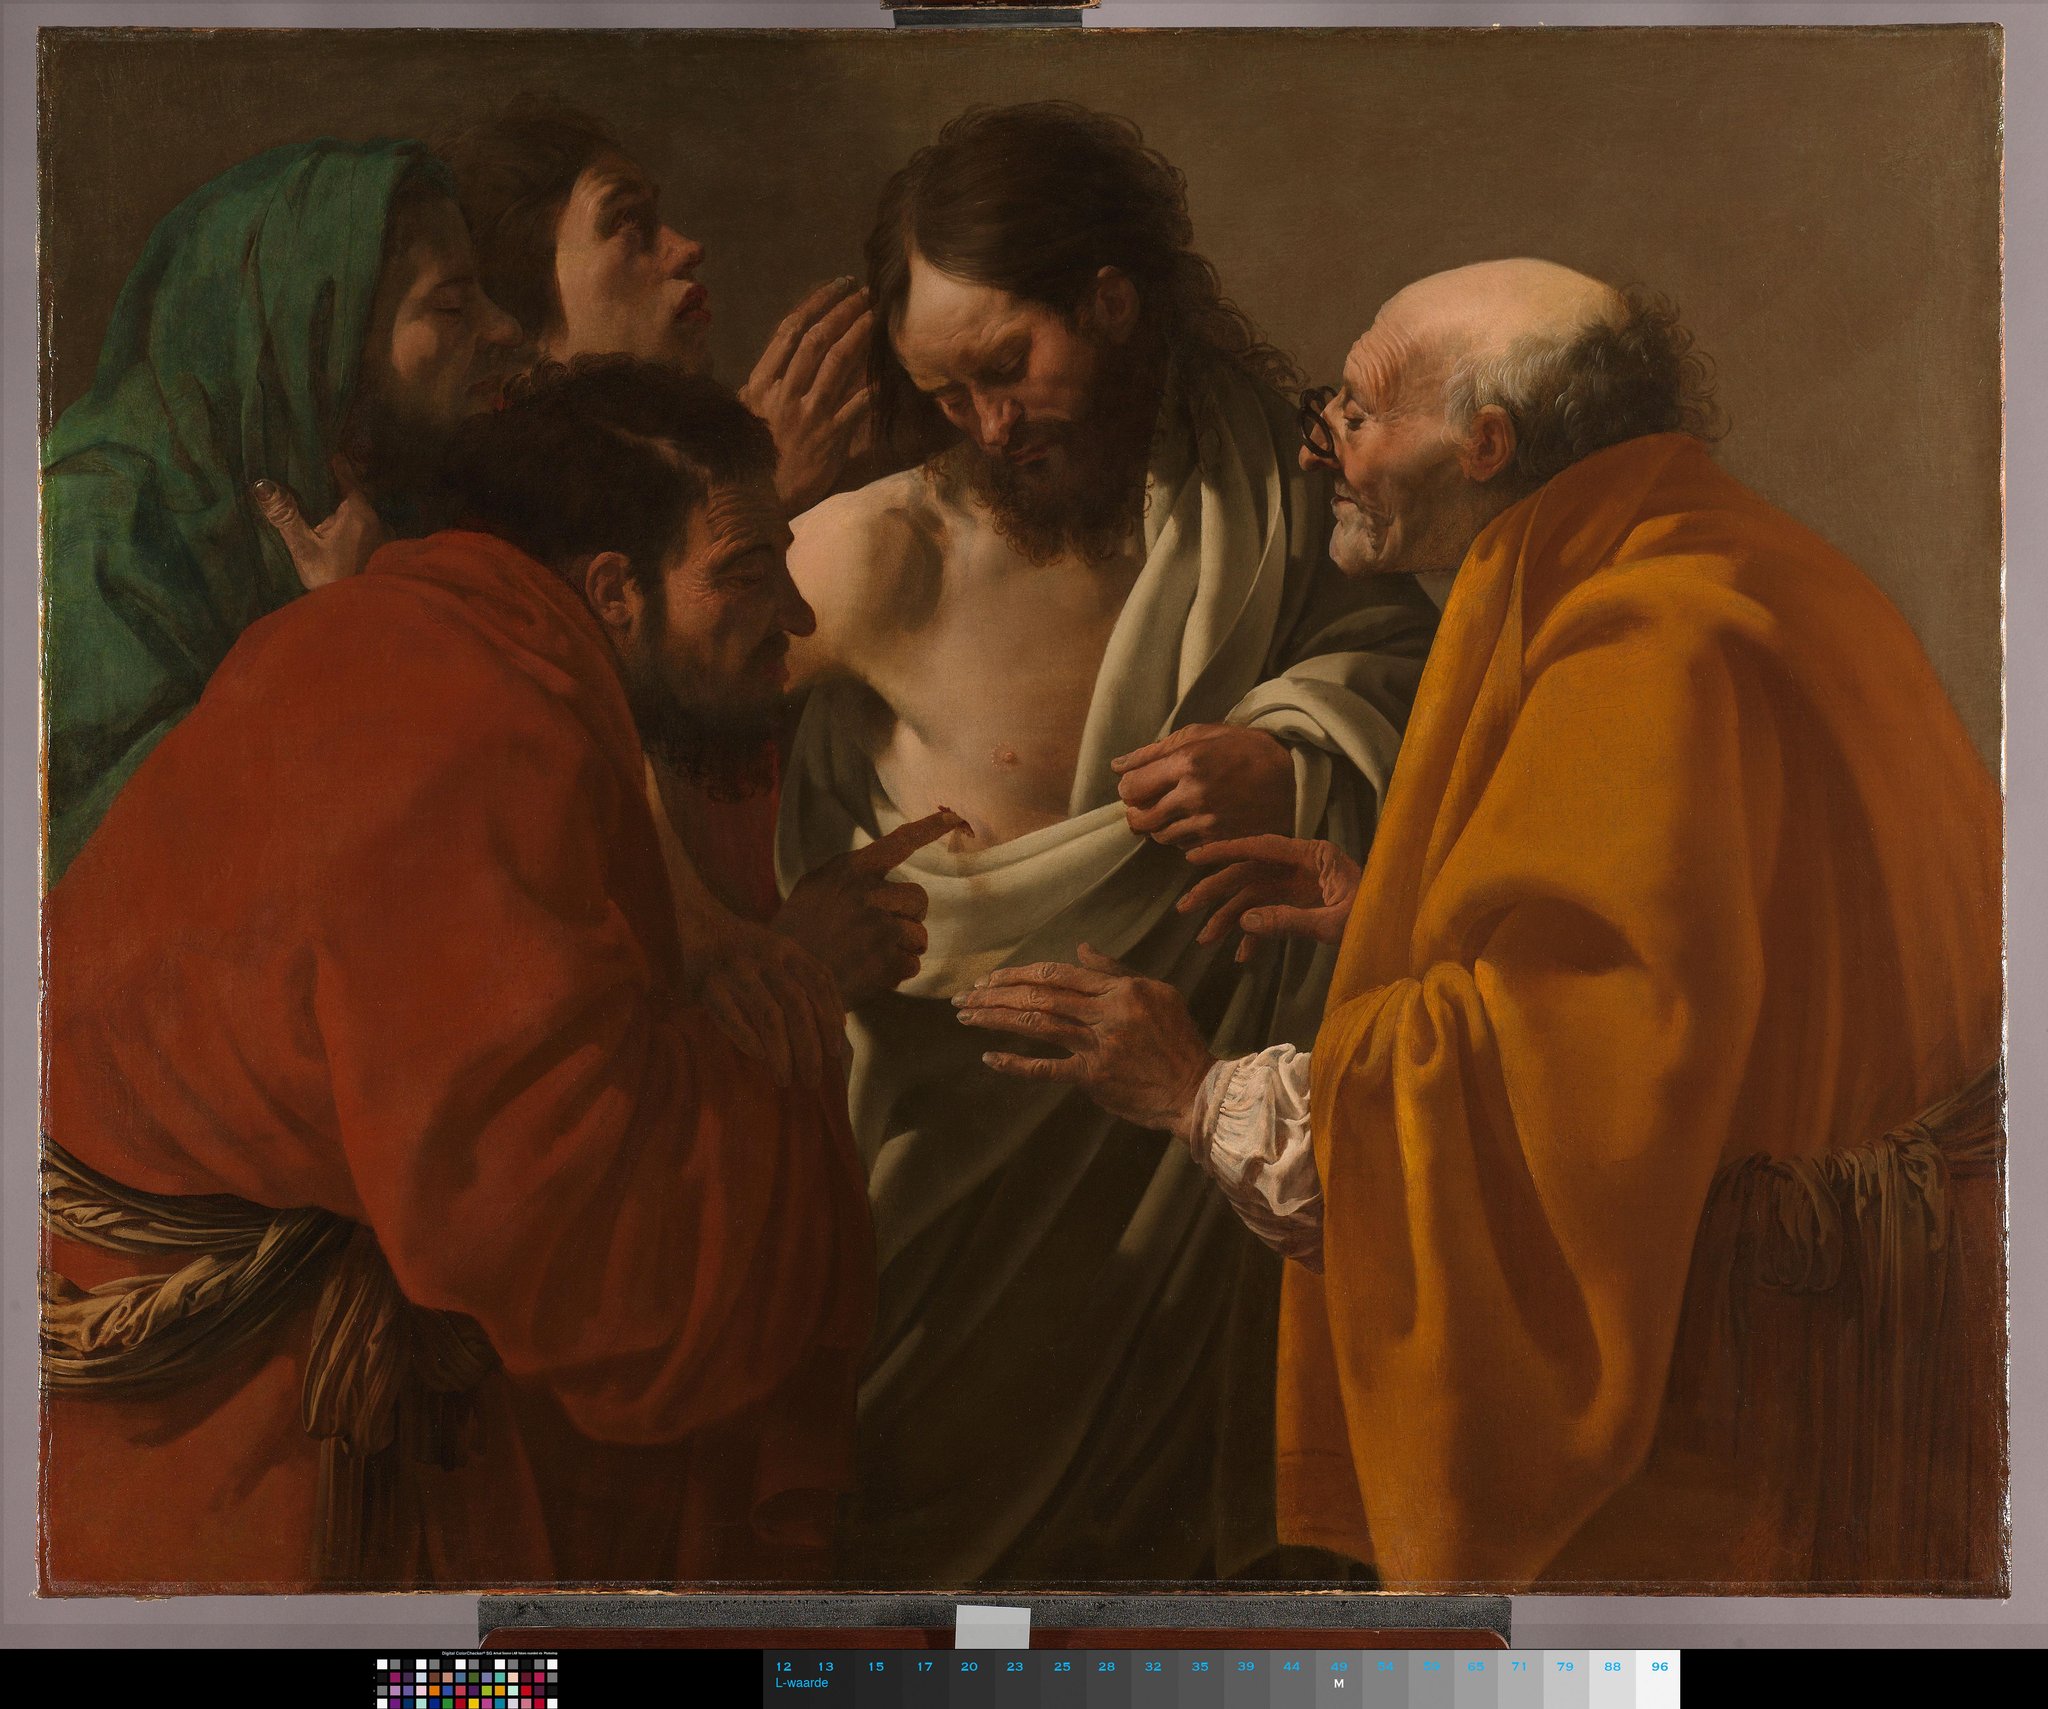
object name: painting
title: The Incredulity of St Thomas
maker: hendrick ter brugghen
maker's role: painter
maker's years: 1588-1629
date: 1622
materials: canvas, oil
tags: thomas touching or stretching out his hands to touch the wound in christ's side, sometimes christ leading thomas' hand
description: Thomas simply could not believe that Christ had actually risen from the dead. His doubts were dispelled only when he had seen and touched the wounds in Christ’s side and hands himself. Emulating his great model Caravaggio, Ter Brugghen portrayed Christ and his followers with craggy faces and wrinkled, rough hands.